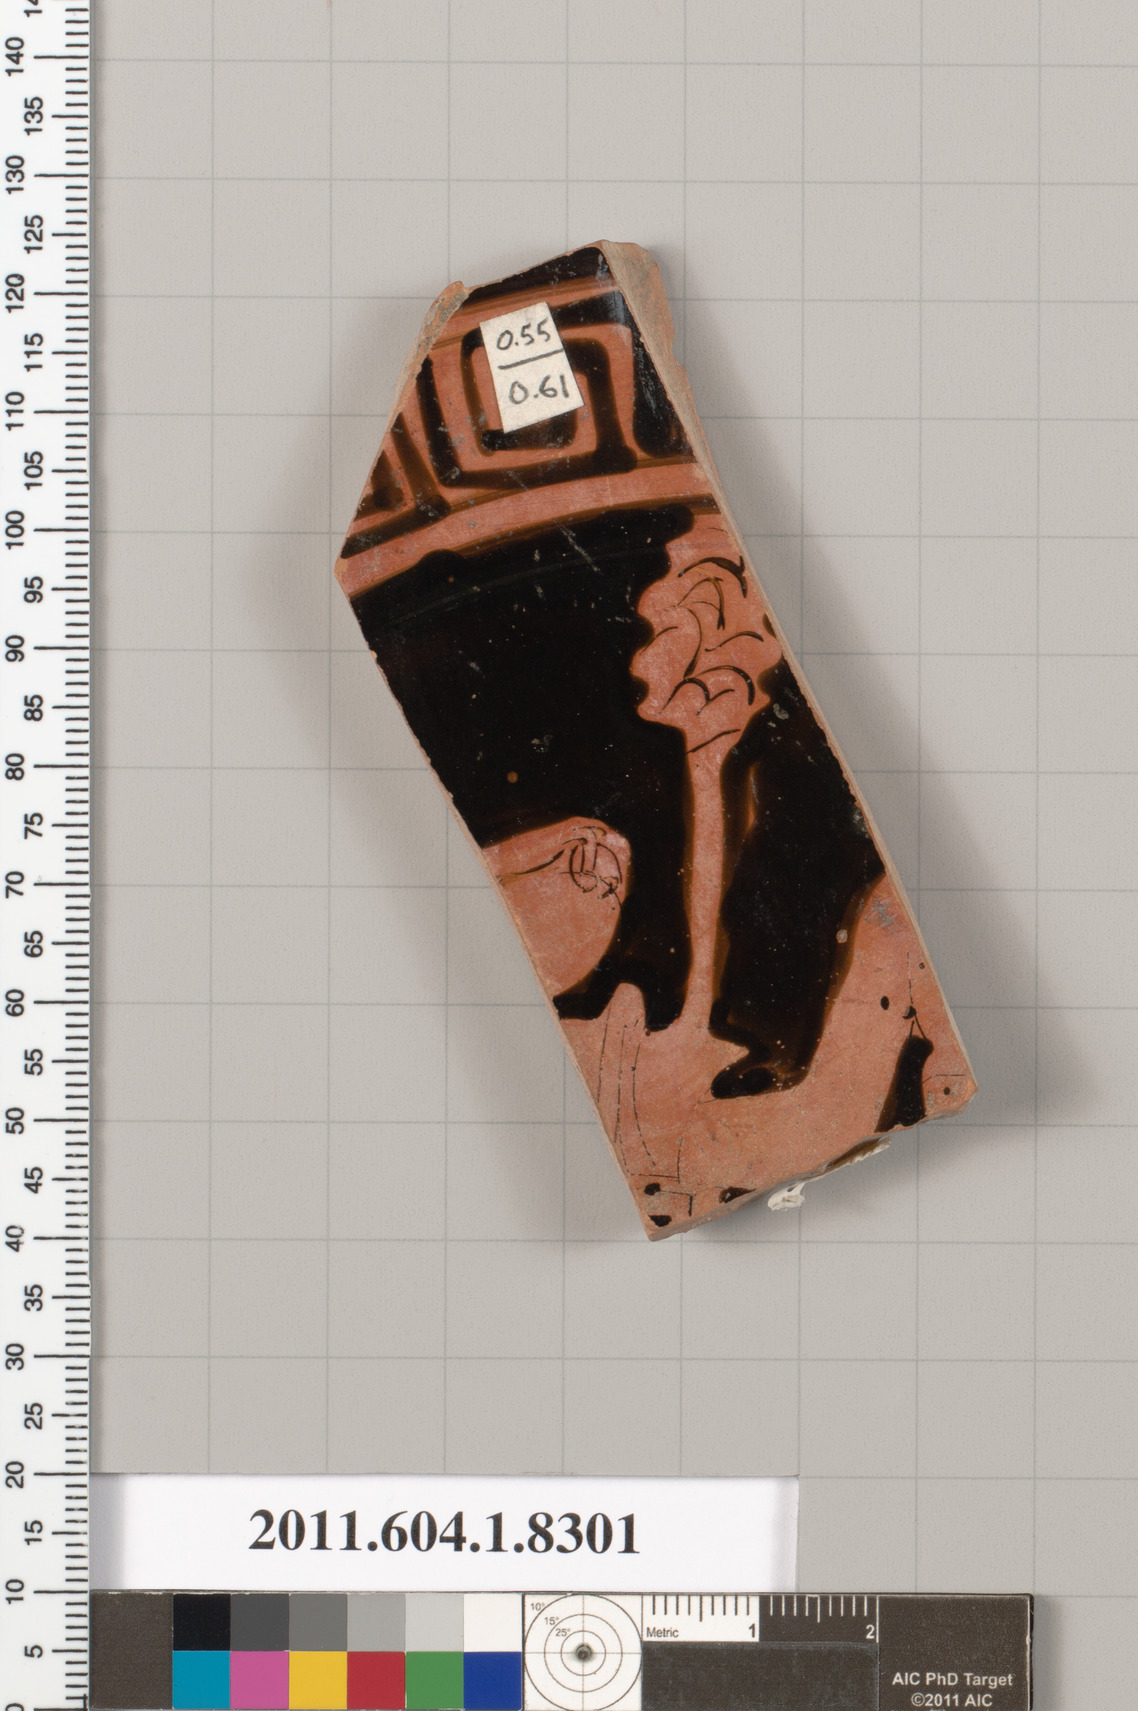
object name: kylix fragment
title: Terracotta fragment of a kylix (drinking cup)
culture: greek, attic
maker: meleager painter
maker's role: artist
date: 400-376 BCE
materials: terracotta